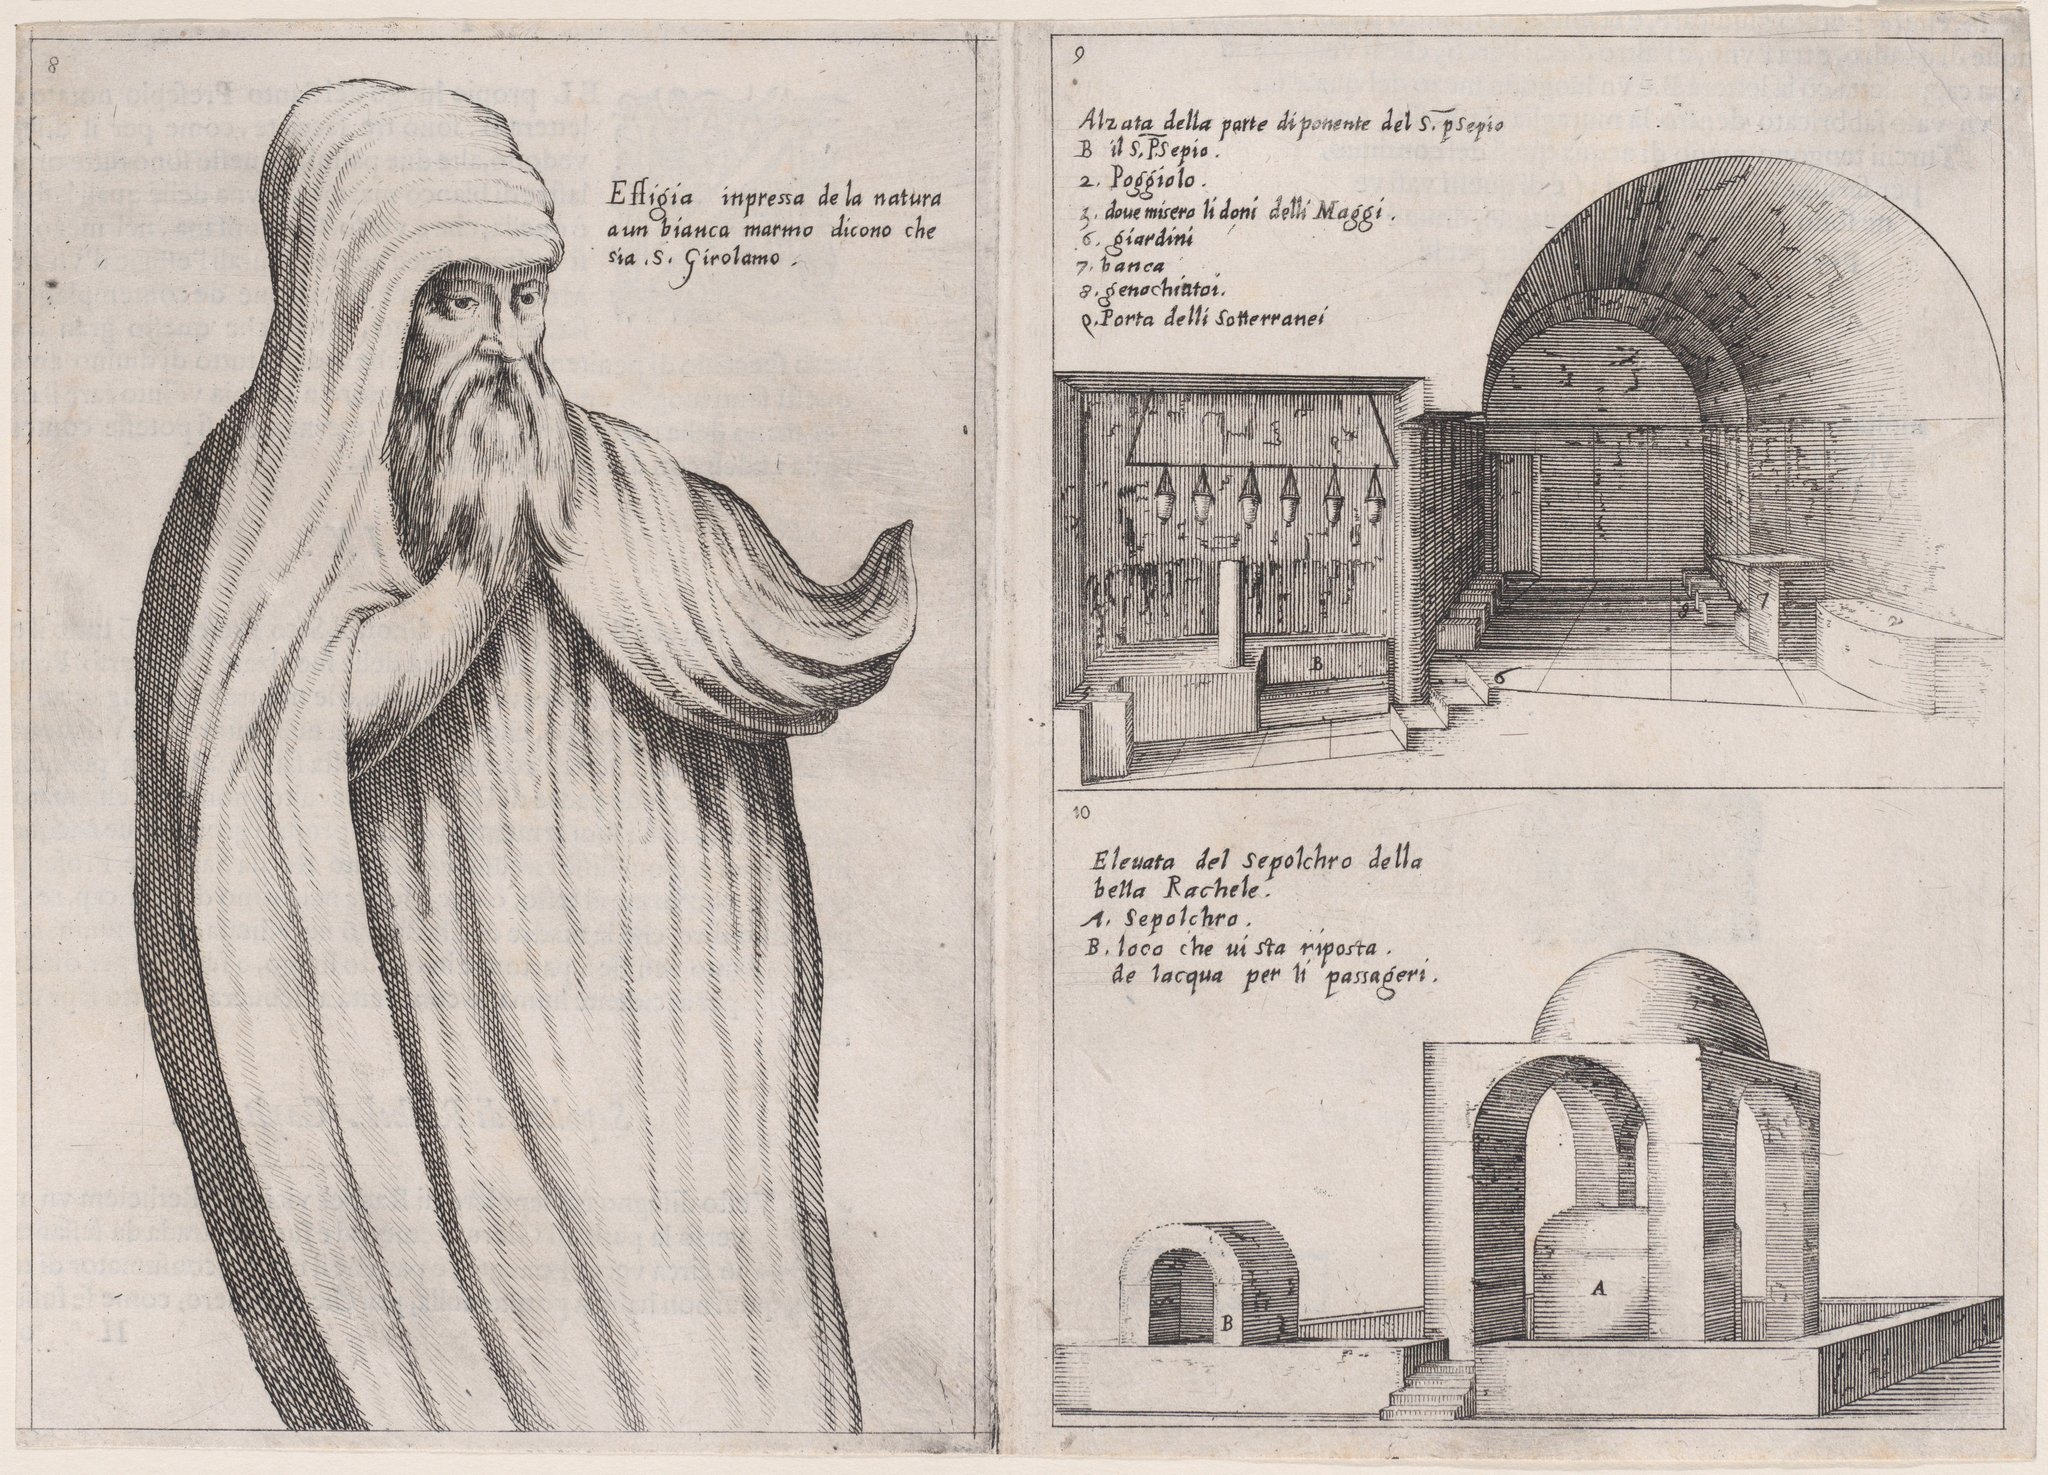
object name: print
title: Plates 7 and 8, from "Trattato delle Piante & Immagini de Sacri Edifizi di Terra Santa" (Treatise of the Plans & Images of the Sacred Buildings of the Holy Land)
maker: jacques callot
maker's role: artist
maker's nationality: french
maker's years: 1592-1635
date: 1620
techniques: engraving, etching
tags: architecture,buildings,men